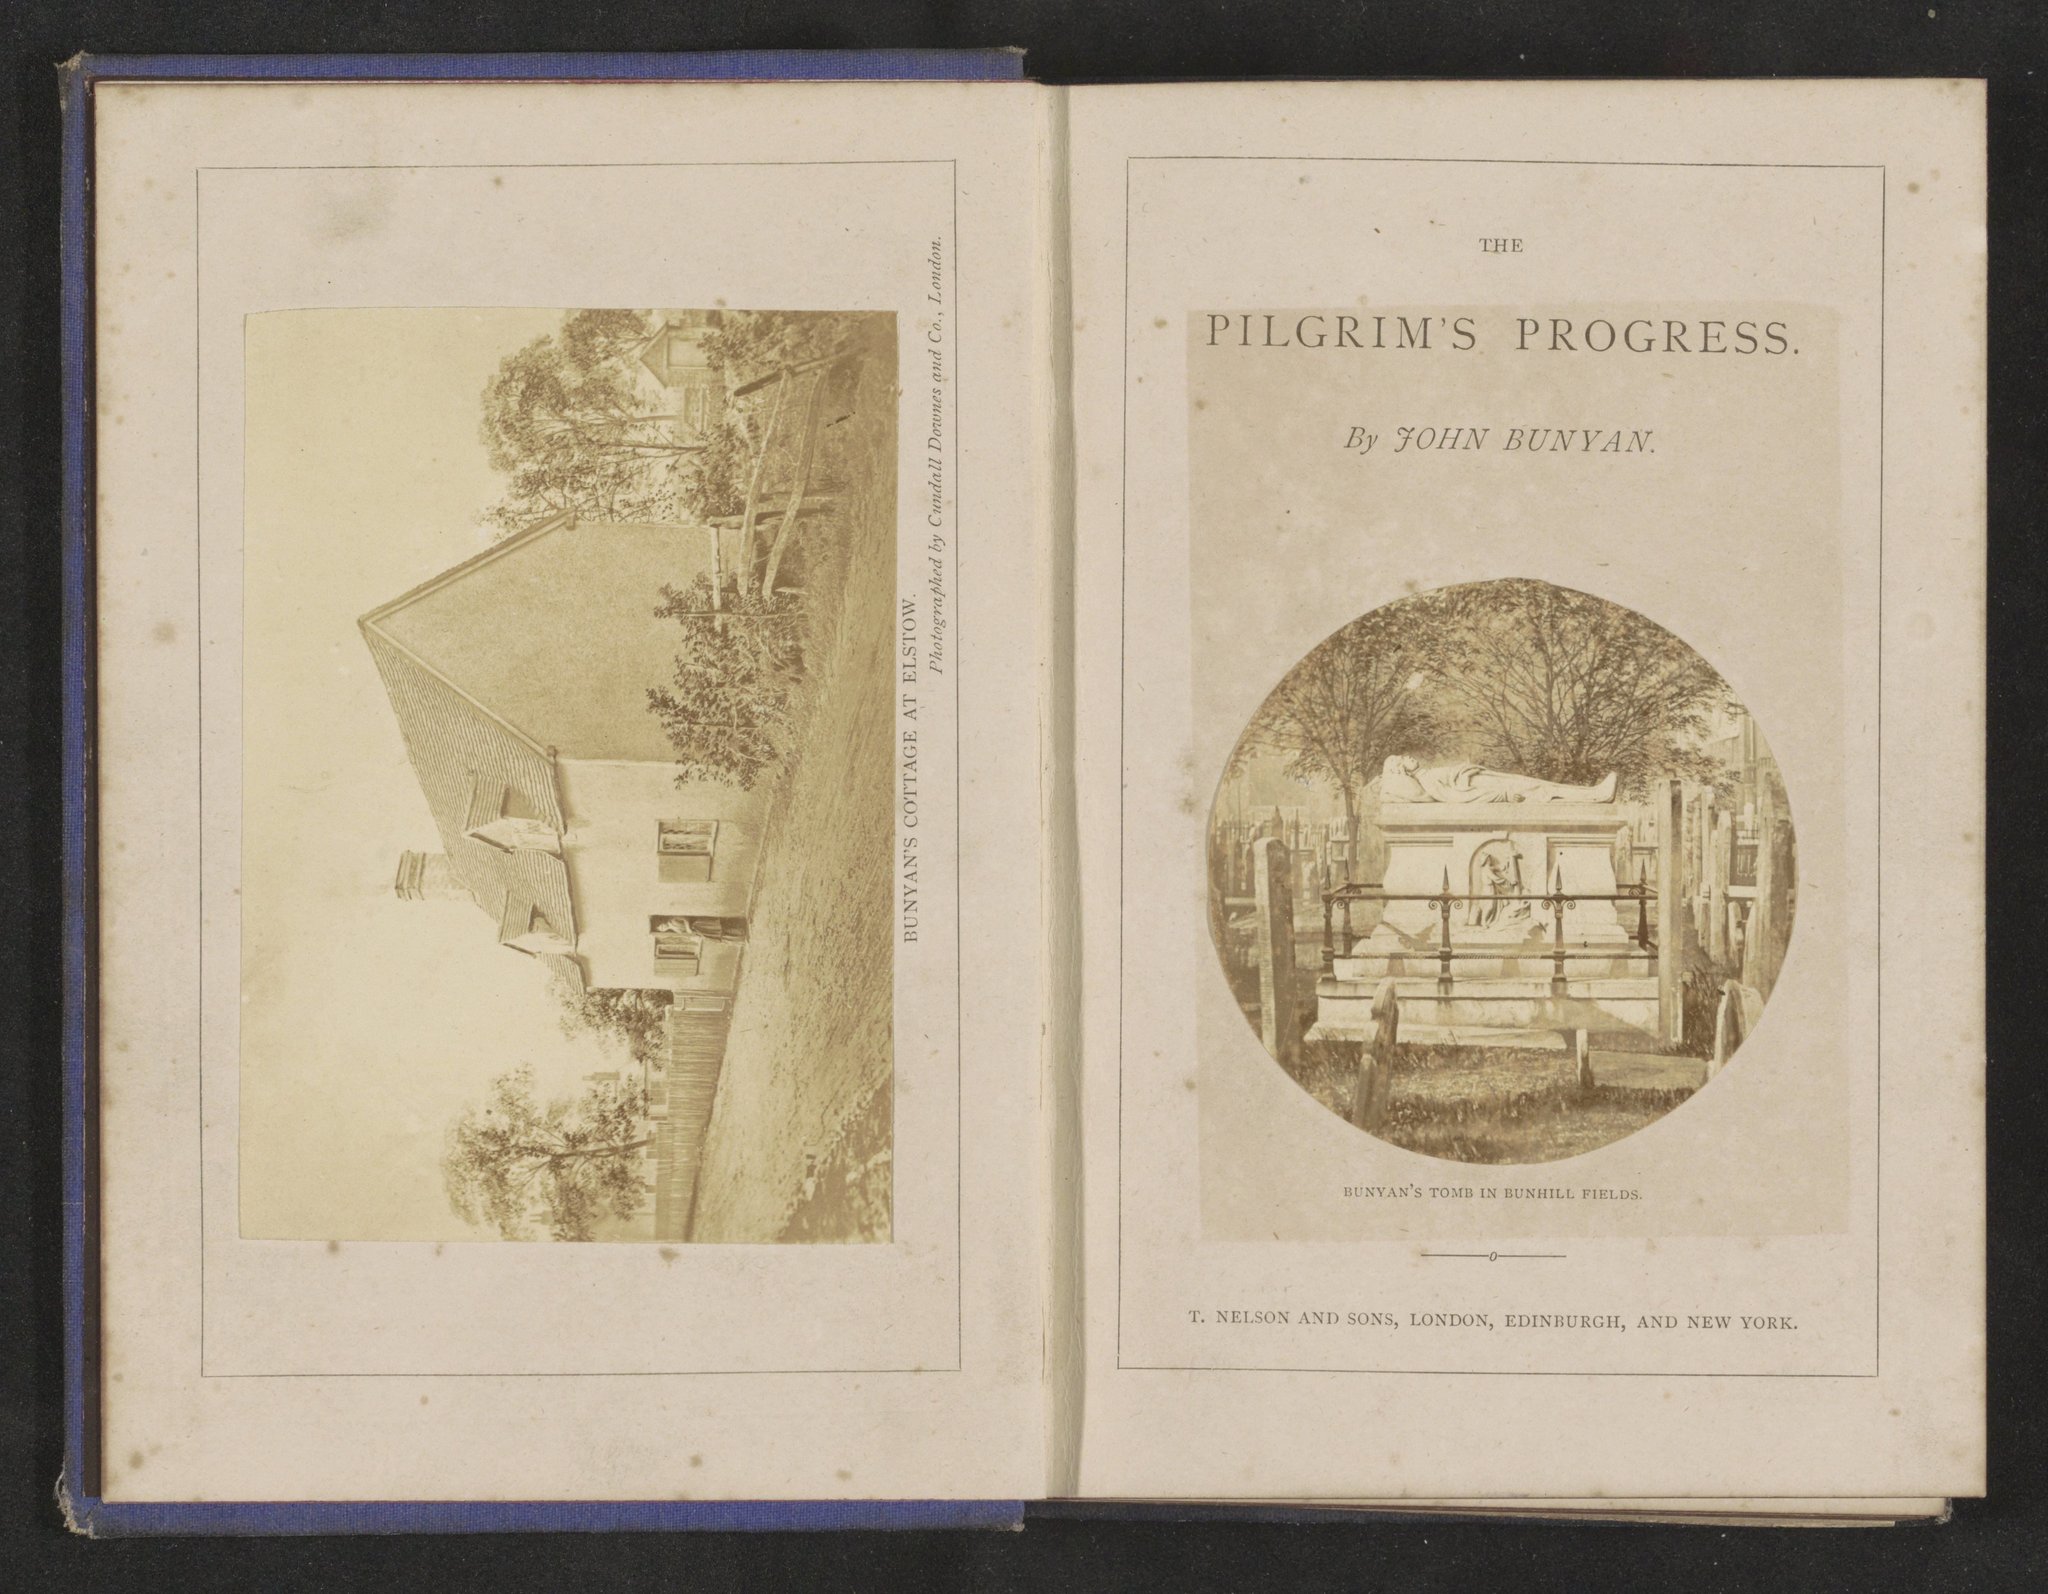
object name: photograph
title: Gezicht op het huis van John Bunyan in Elstow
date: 1856-1866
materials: photographic support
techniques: albumen print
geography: elstow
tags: cottage